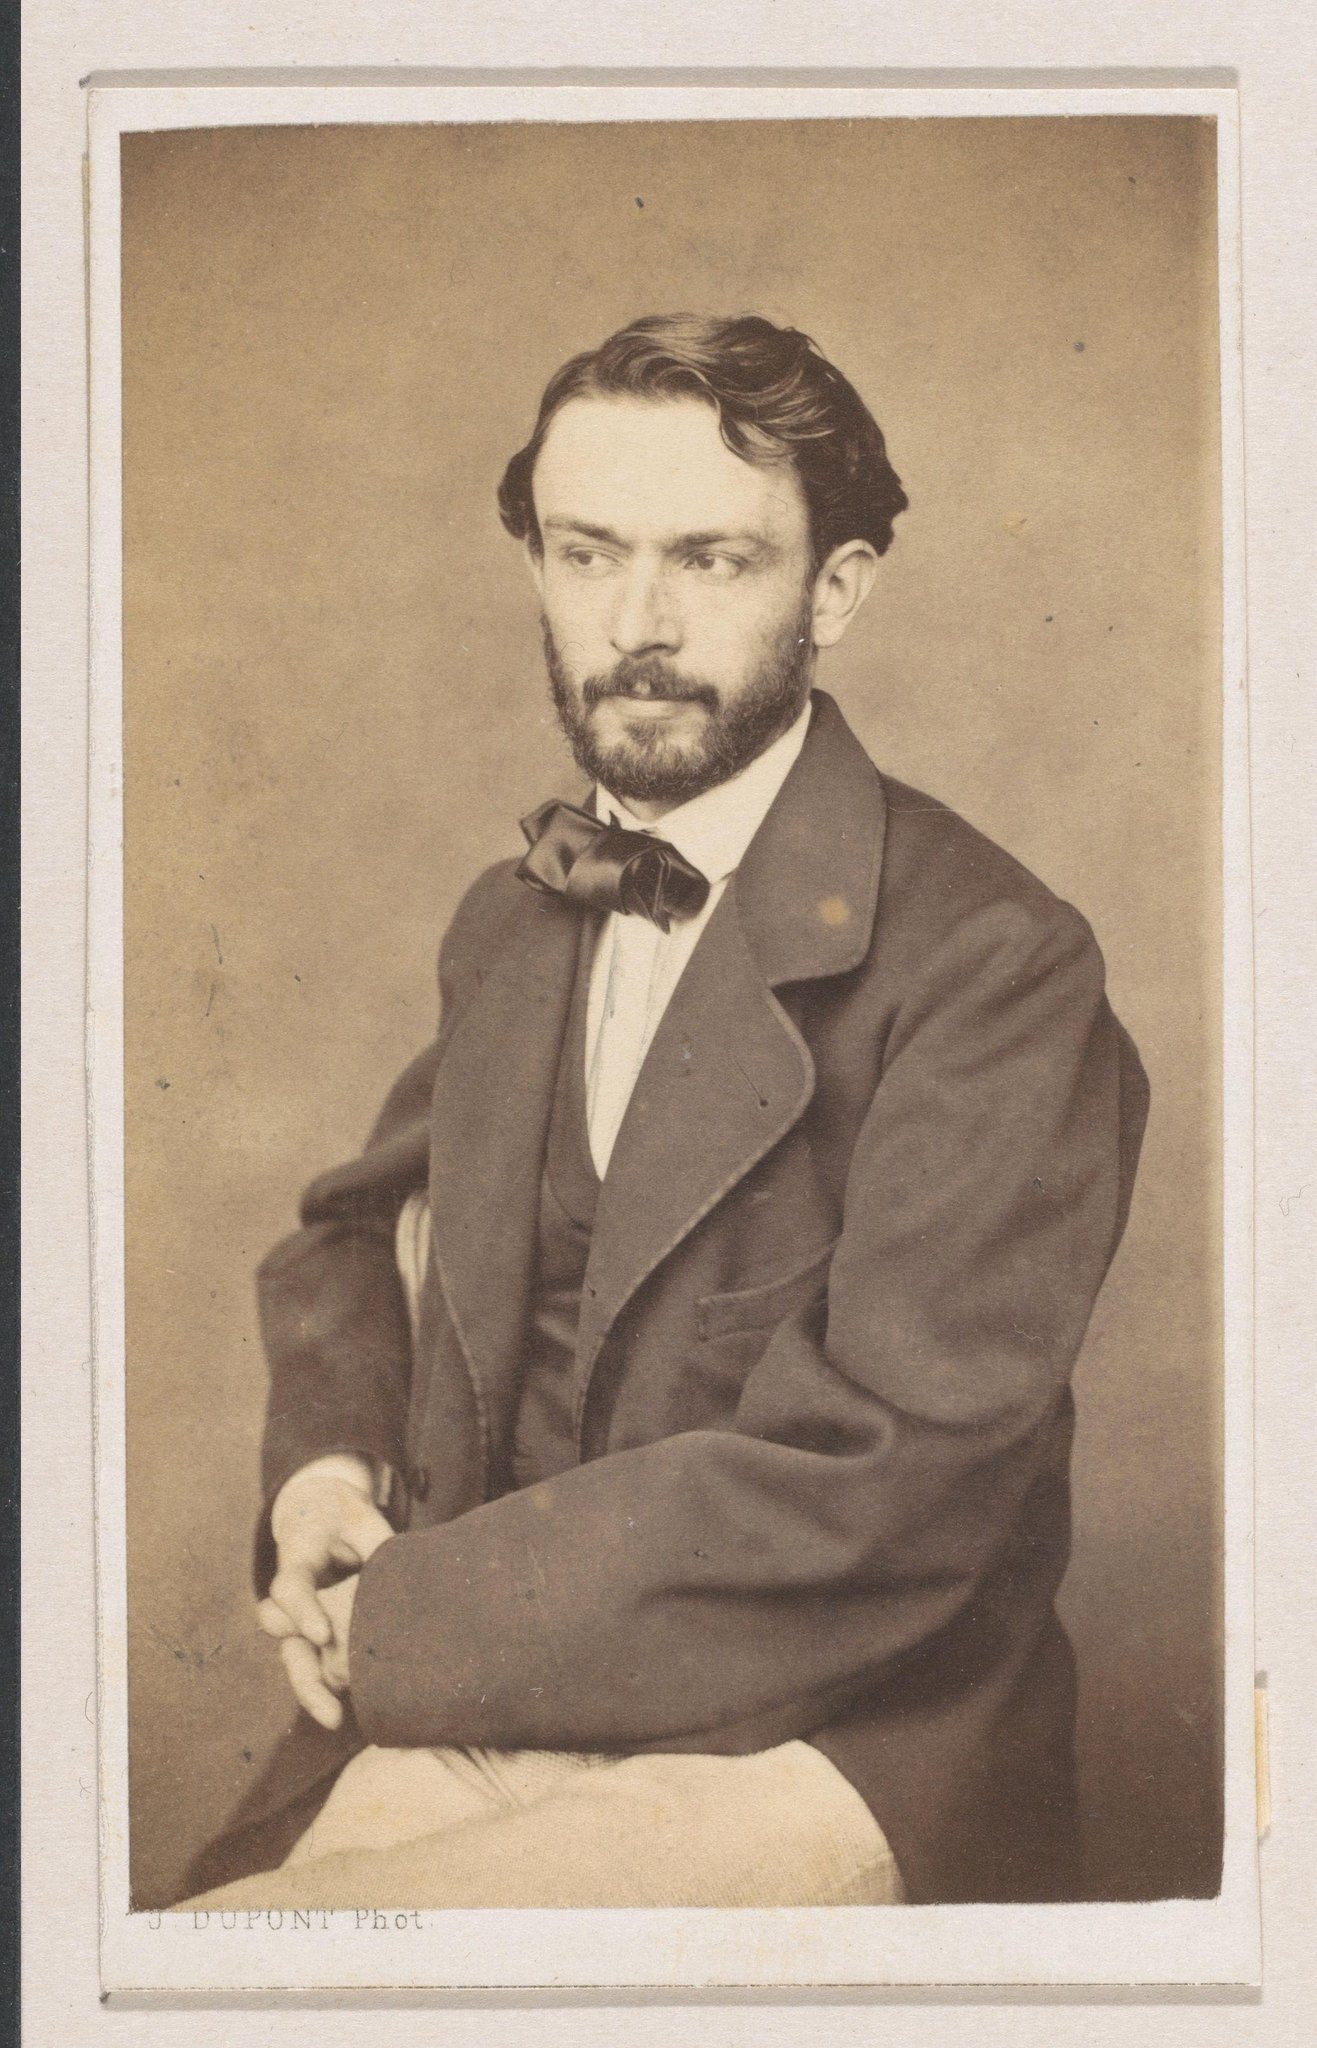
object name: carte de visite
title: L'École d'Anvers. Portraits biographies cartes de visite. Collection Dupont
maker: joseph dupont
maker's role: fotograaf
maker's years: 1818-1901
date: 1861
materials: cardboard, paper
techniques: albumen print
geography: antwerp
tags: antwerp, sculptor, portrait, self-portrait of sculptor, historical persons, portrait, self-portrait of painter, portrait, self-portrait of artist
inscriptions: inscription: ‘ETABLISSEMENT PHOTOGRAPHIQUE/ de/ J. DUPONT/ Place de Meir 32/ ANVERS/ Maison fondée en 1853’